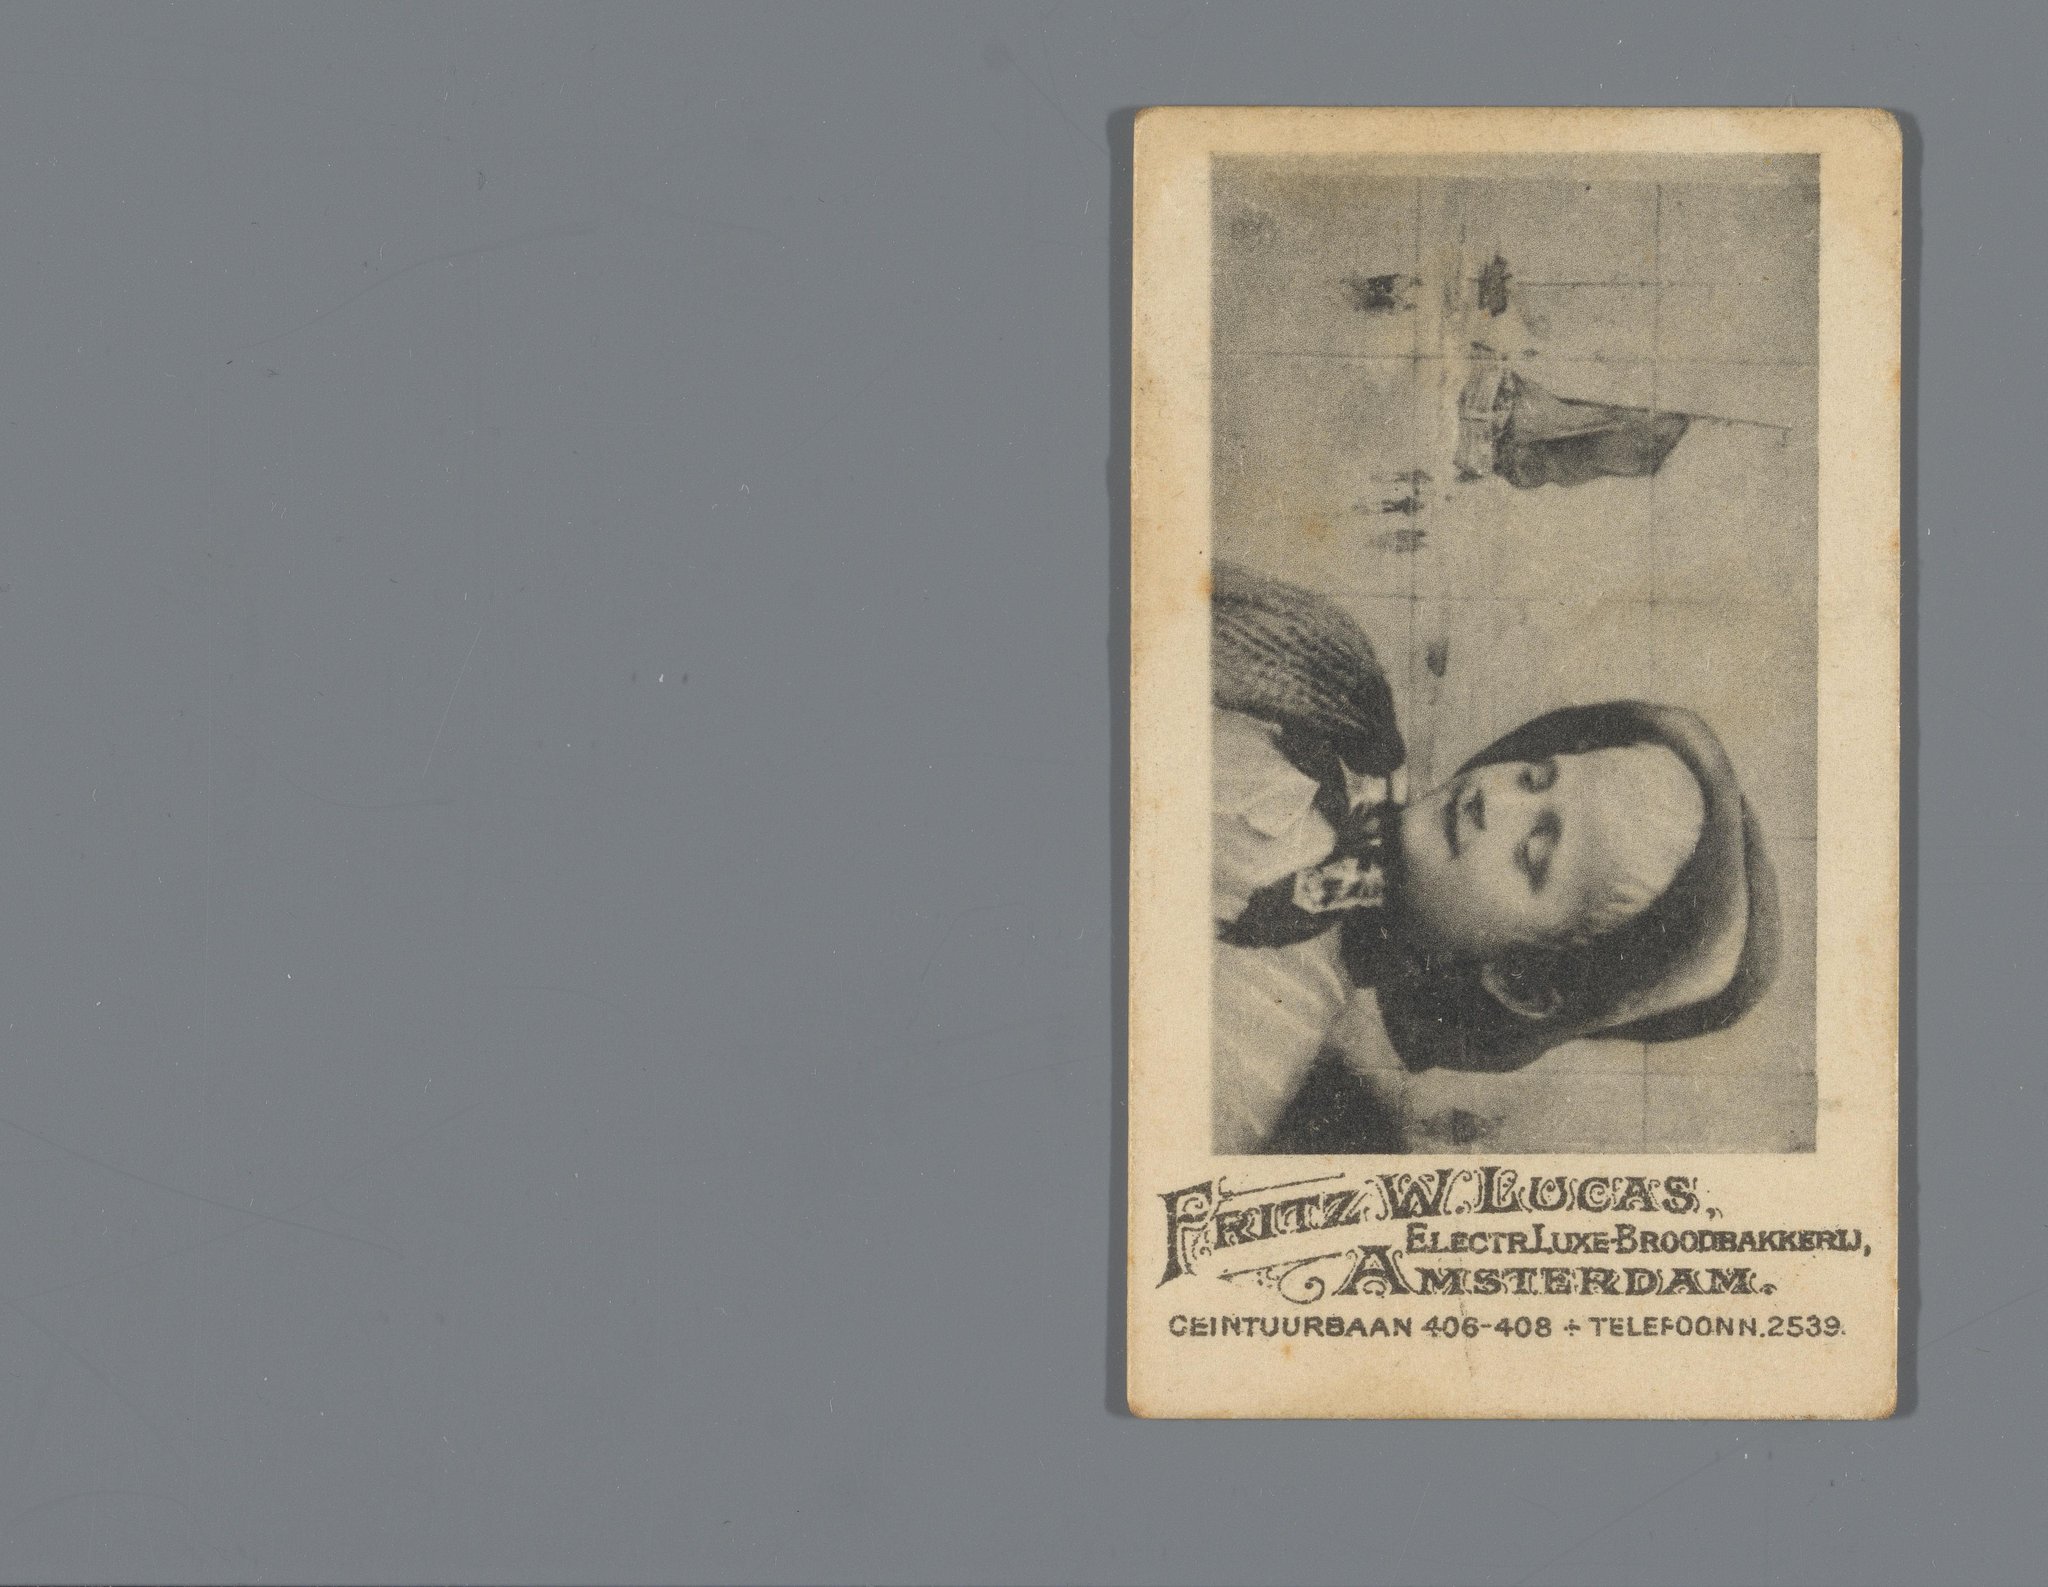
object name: photomechanical print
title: Jongen voor tegeltableau met zeescène, reclame voor Fritz W. Lucas, Electrische Luxe-Broodbakkerij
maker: Anonymous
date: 1895-1910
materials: paper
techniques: photograph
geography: netherlands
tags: boy (child between toddler and youth), netherlands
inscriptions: address: ‘Amsterdam,/ CEINTUURBAAN 406-408 + TELEFOONN. 2539.’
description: Dergelijke prenten stonden bekend als 'zwartjes'. Men verkreeg ze bij aanschaf van bepaalde merken thee, cacao, sigaretten, beschuit, etc. om te verzamelen. Er waren speciaal voor de 'zwartjes' verzamelalbums in omloop.